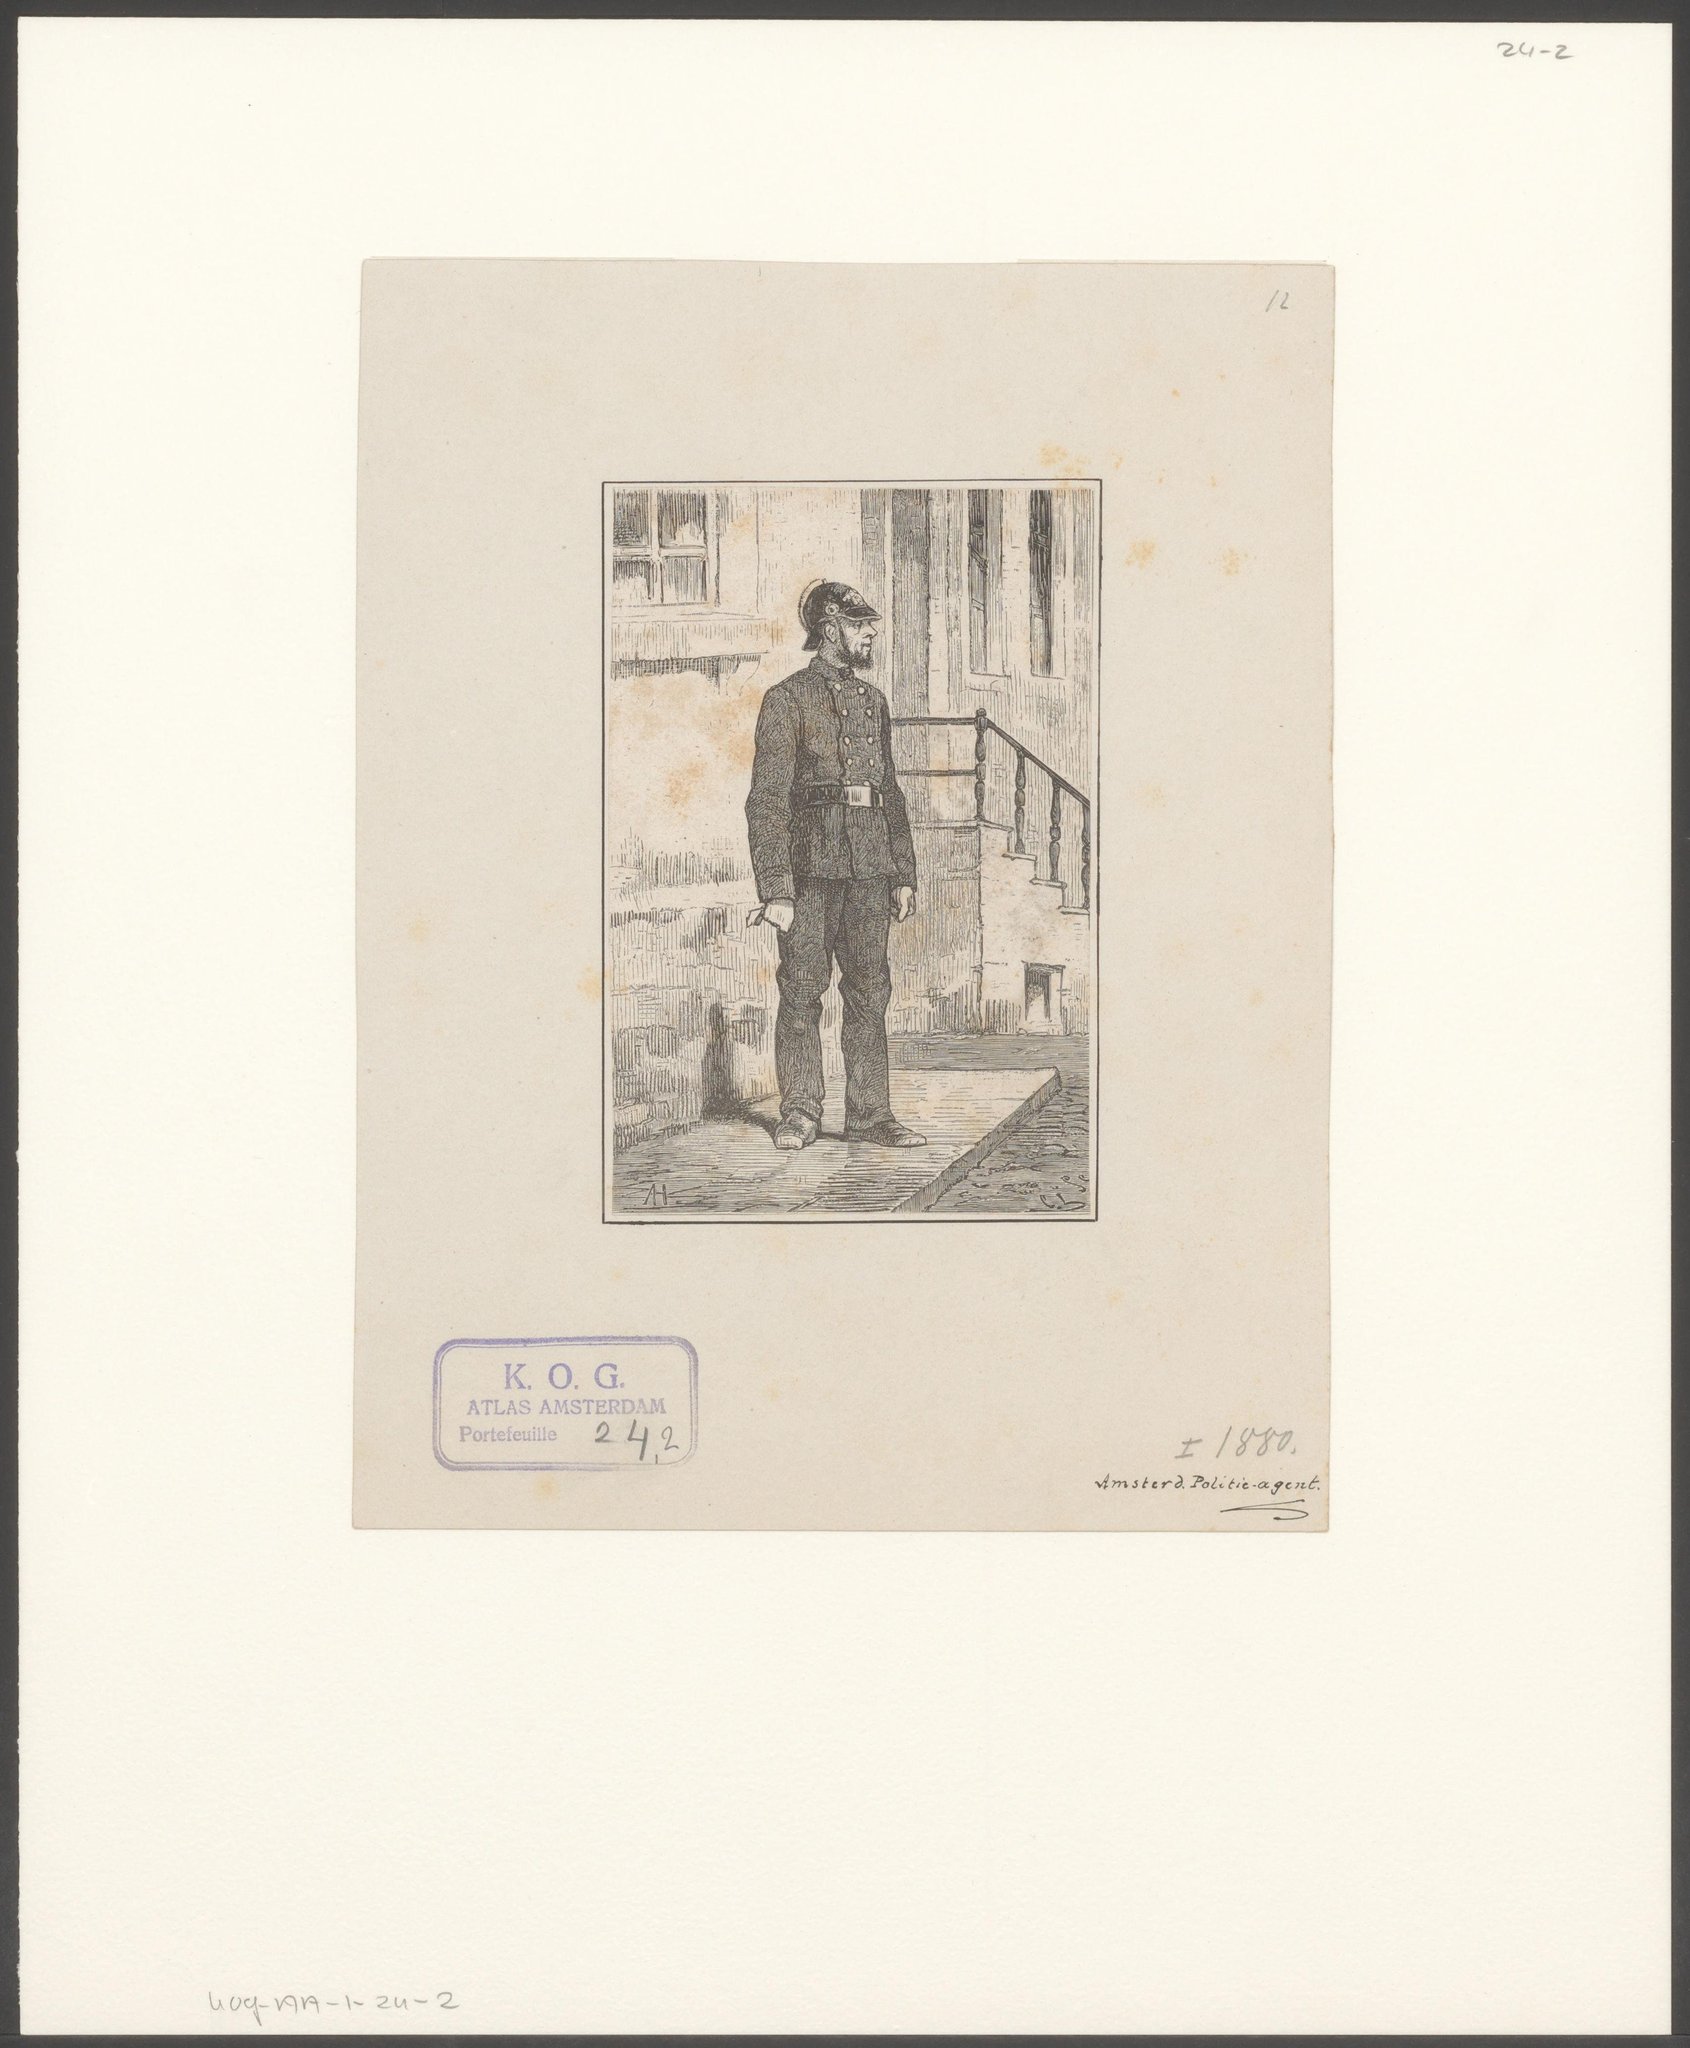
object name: print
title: Amsterdamse politieagent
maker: Anonymous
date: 1870-1890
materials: paper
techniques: engraving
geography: netherlands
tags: policeman, constable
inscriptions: signature: ‘C.b. (?) Sc’, signature: ‘AH (?)’, collector's mark: Lugt 1641b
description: Onderwerpsrubriek binnen de Atlas Amsterdam: Politie.